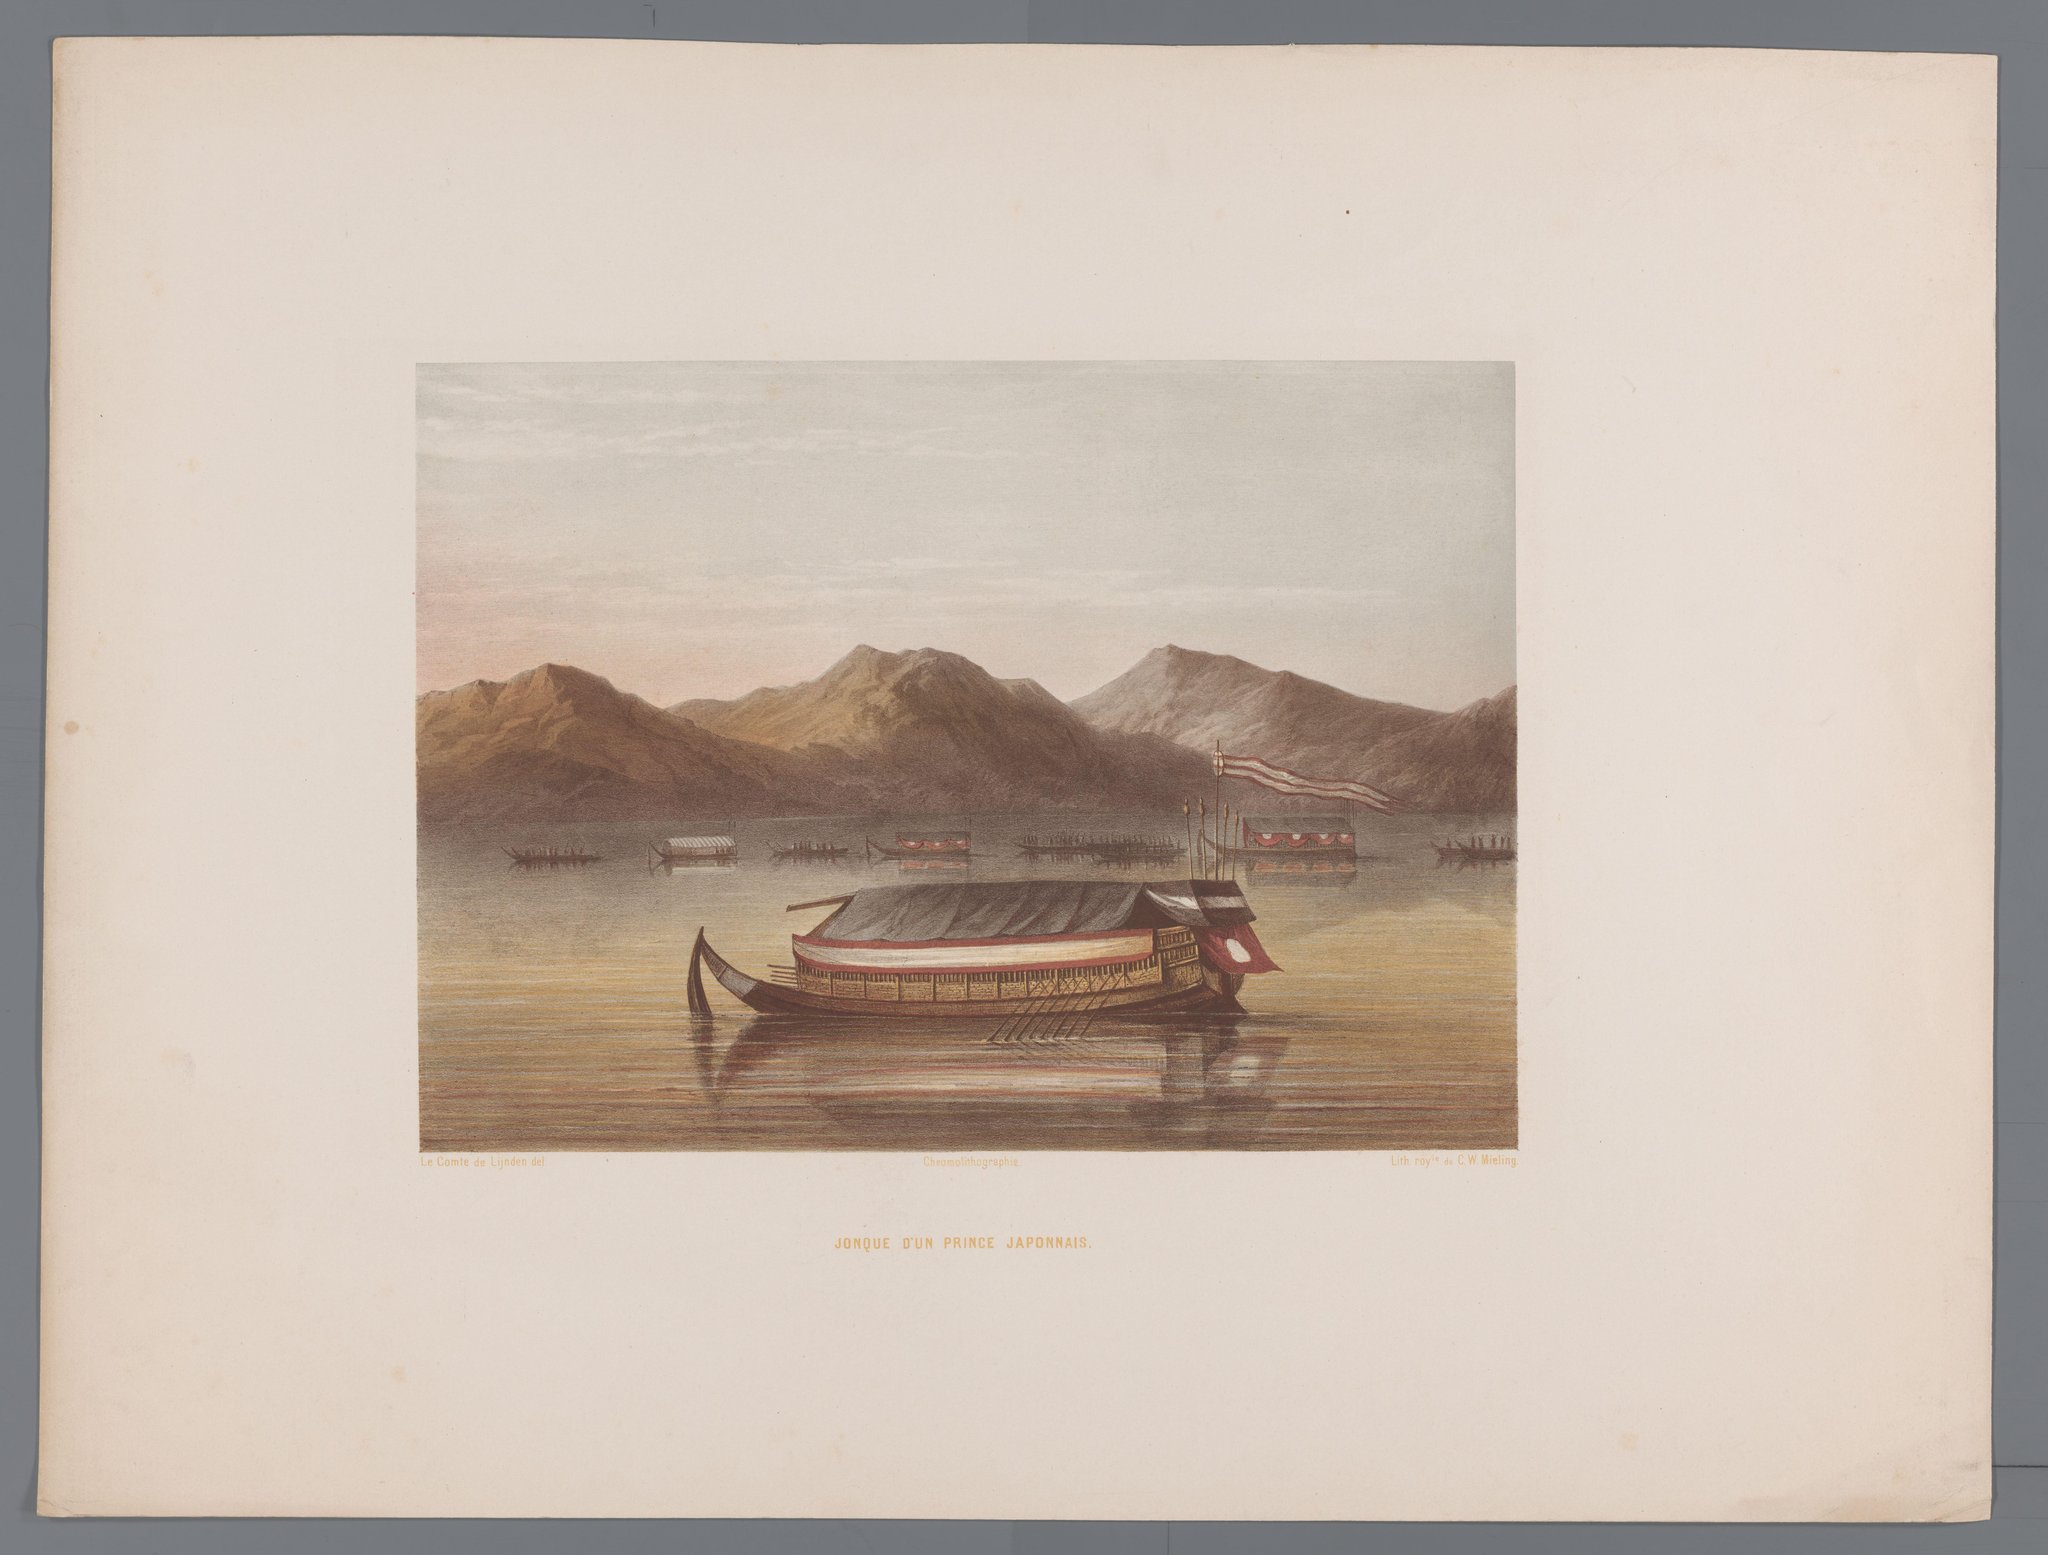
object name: print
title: Jonk van een Japanse prins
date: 1862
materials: paper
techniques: chromolithography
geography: the hague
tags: prince, rowing-boat, canoe, etc., japan